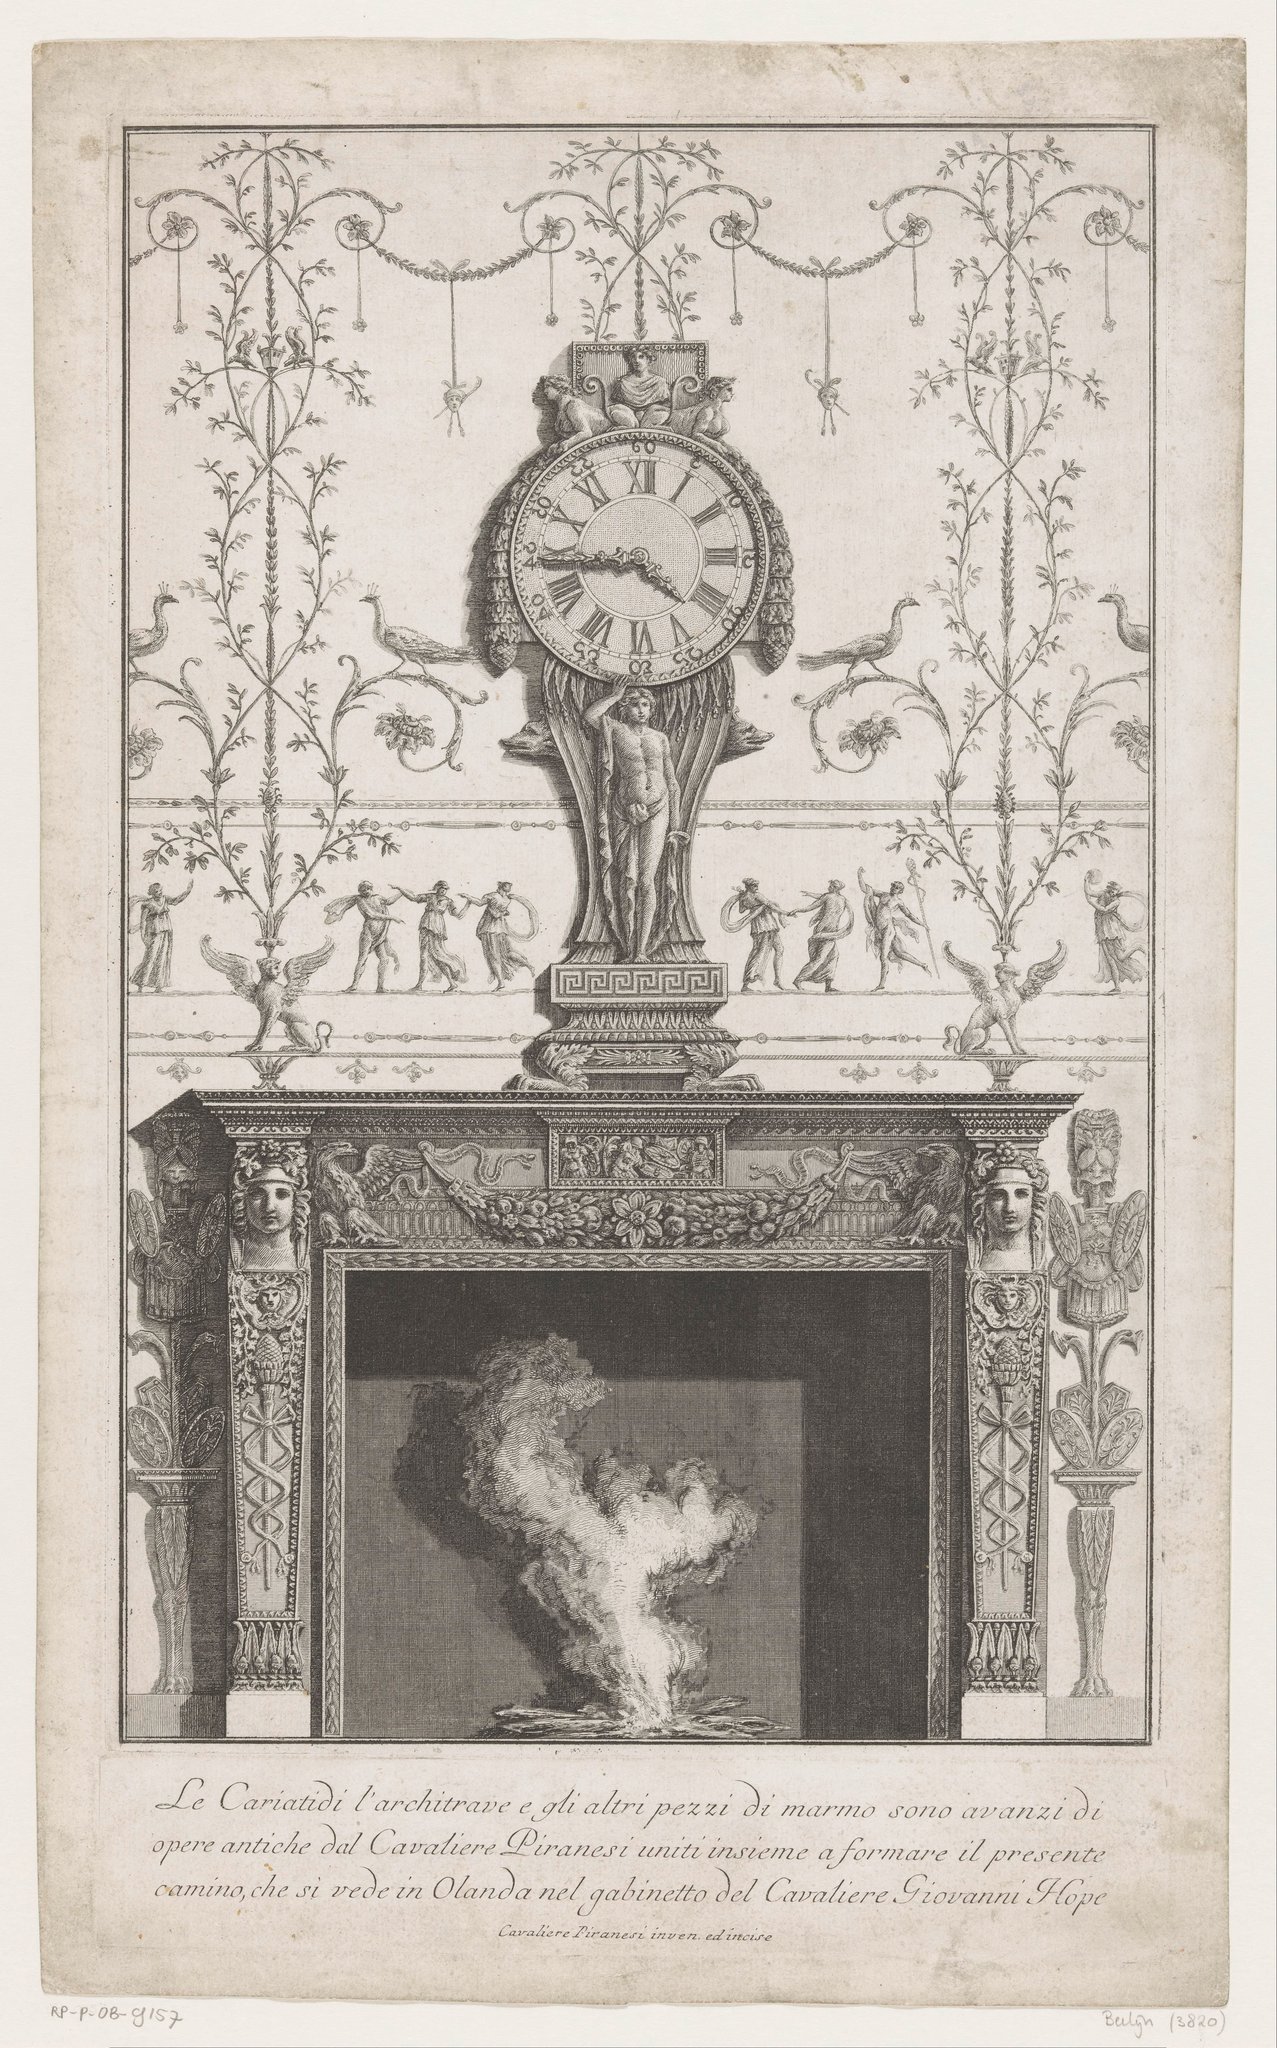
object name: ornament print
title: Ontwerpen van decoraties voor schoorsteenmantels en andere delen van het huis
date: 1769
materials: paper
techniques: etching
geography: rome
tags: ornament ~ grotesque, ornaments ~ art, open hearth, fire-place, clock, ornament ~ cartouche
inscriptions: collector's mark: Lugt 2760, collector's mark: ‘RIJKS / MUSM’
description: Deze prent maakt deel uit van een reeks van 67 prenten van ontwerpen voor onder andere schoorsteenmantels. Deze schoorsteenmantel was ontworpen voor John Hope.